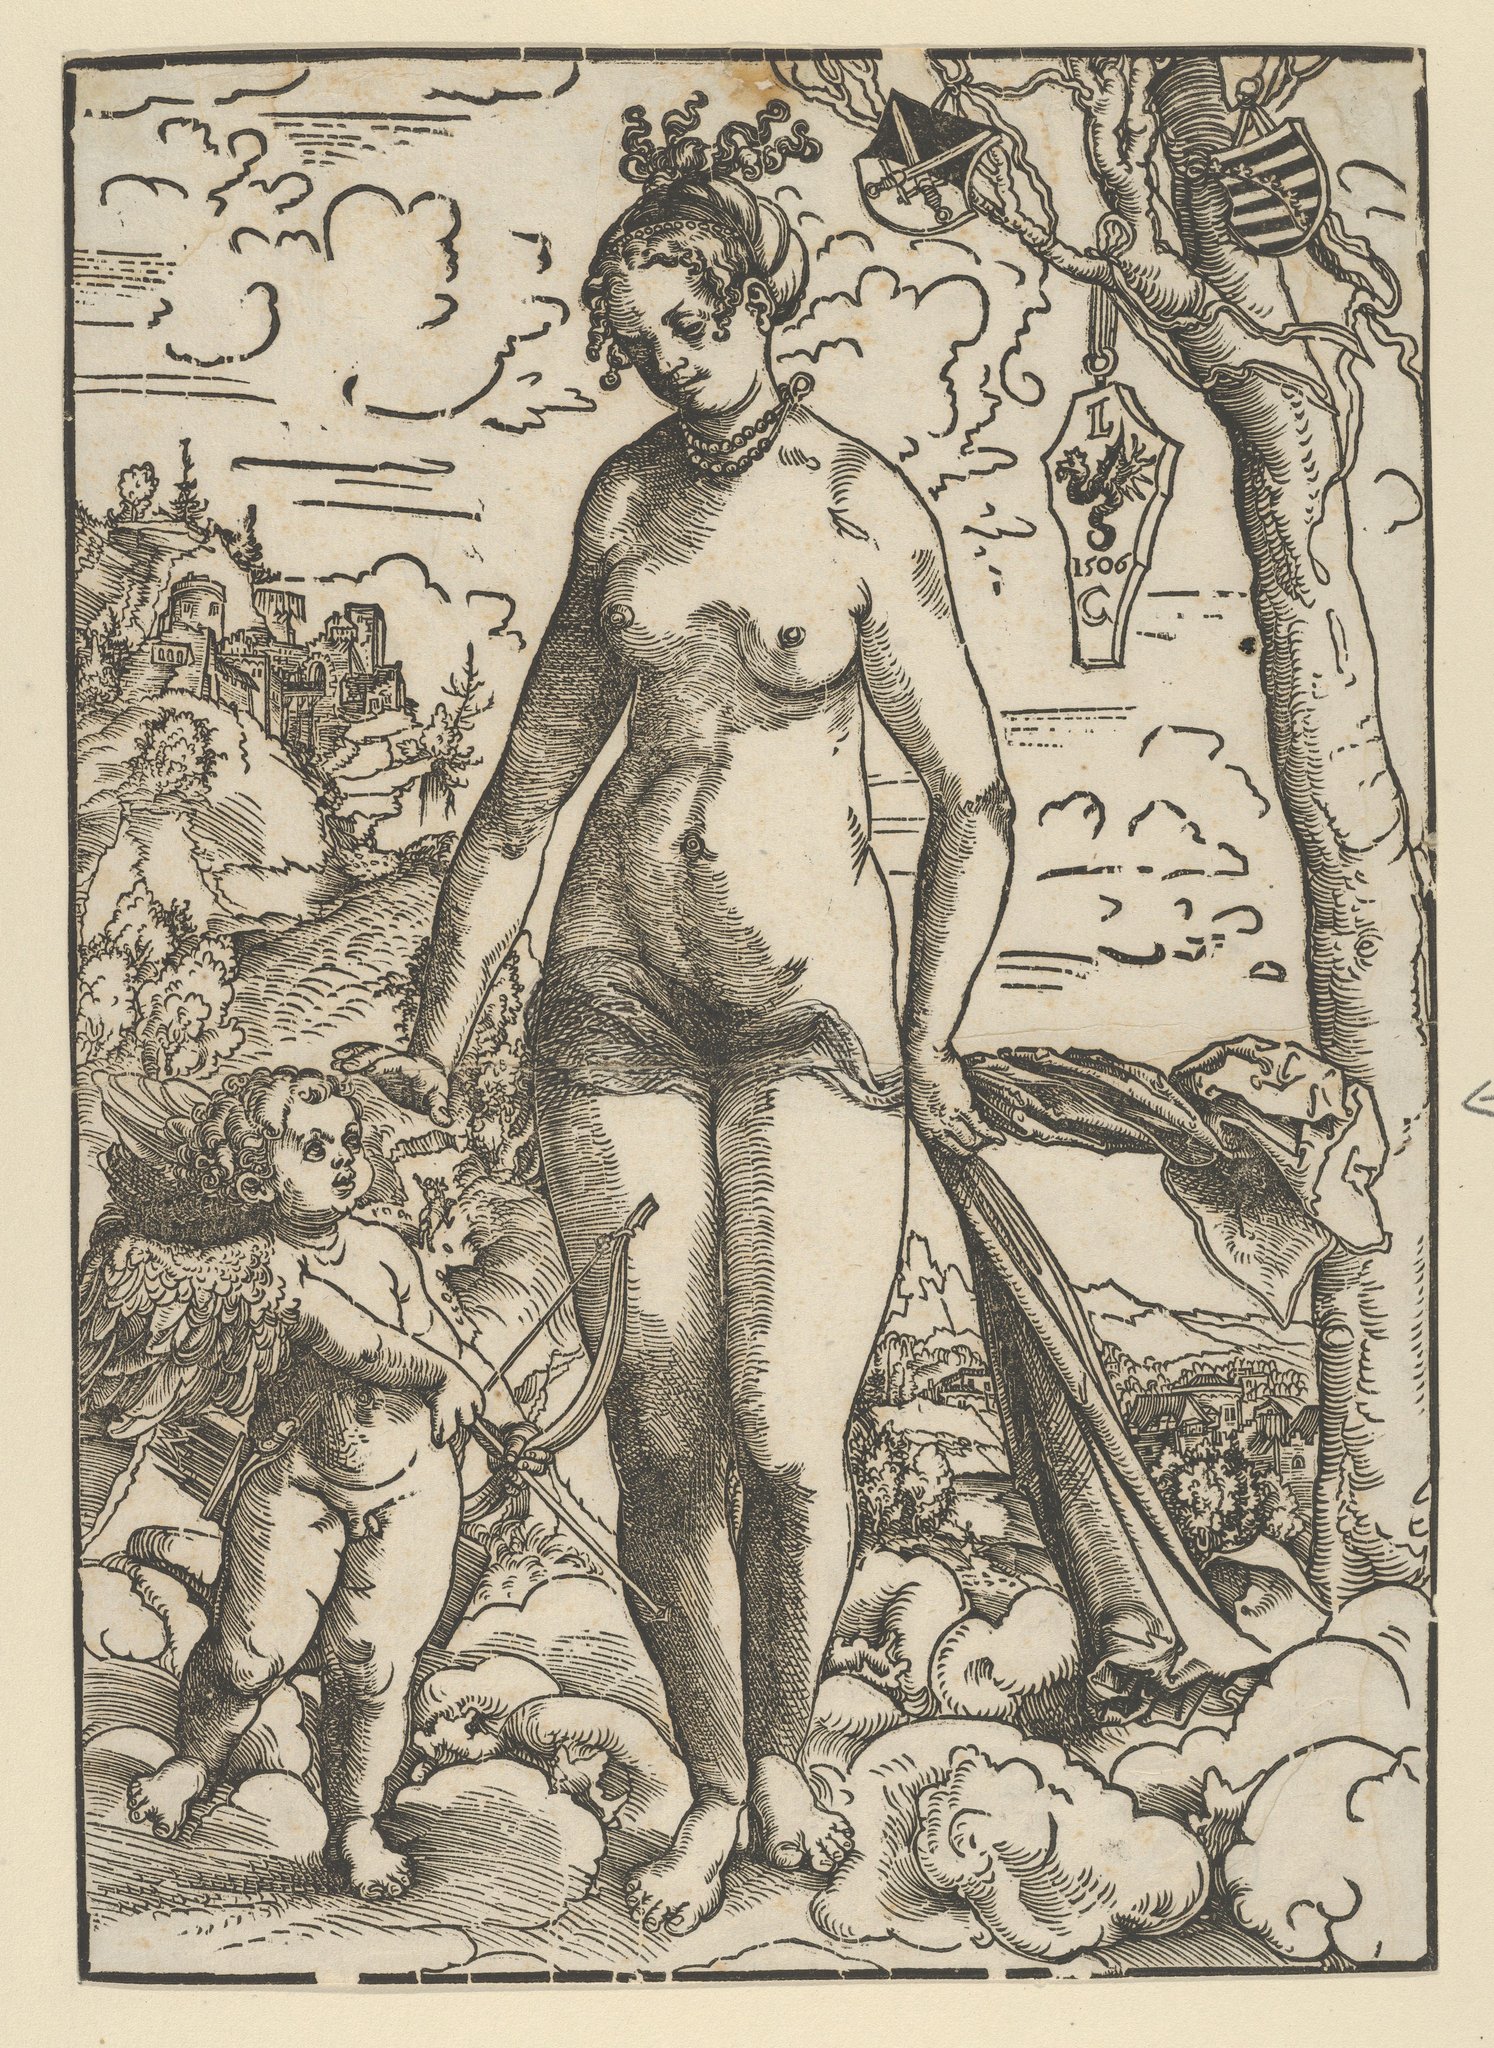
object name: print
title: Venus and Cupid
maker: lucas cranach the elder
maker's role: artist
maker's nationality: german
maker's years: 1472-1553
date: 1506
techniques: woodcut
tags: cupid,venus